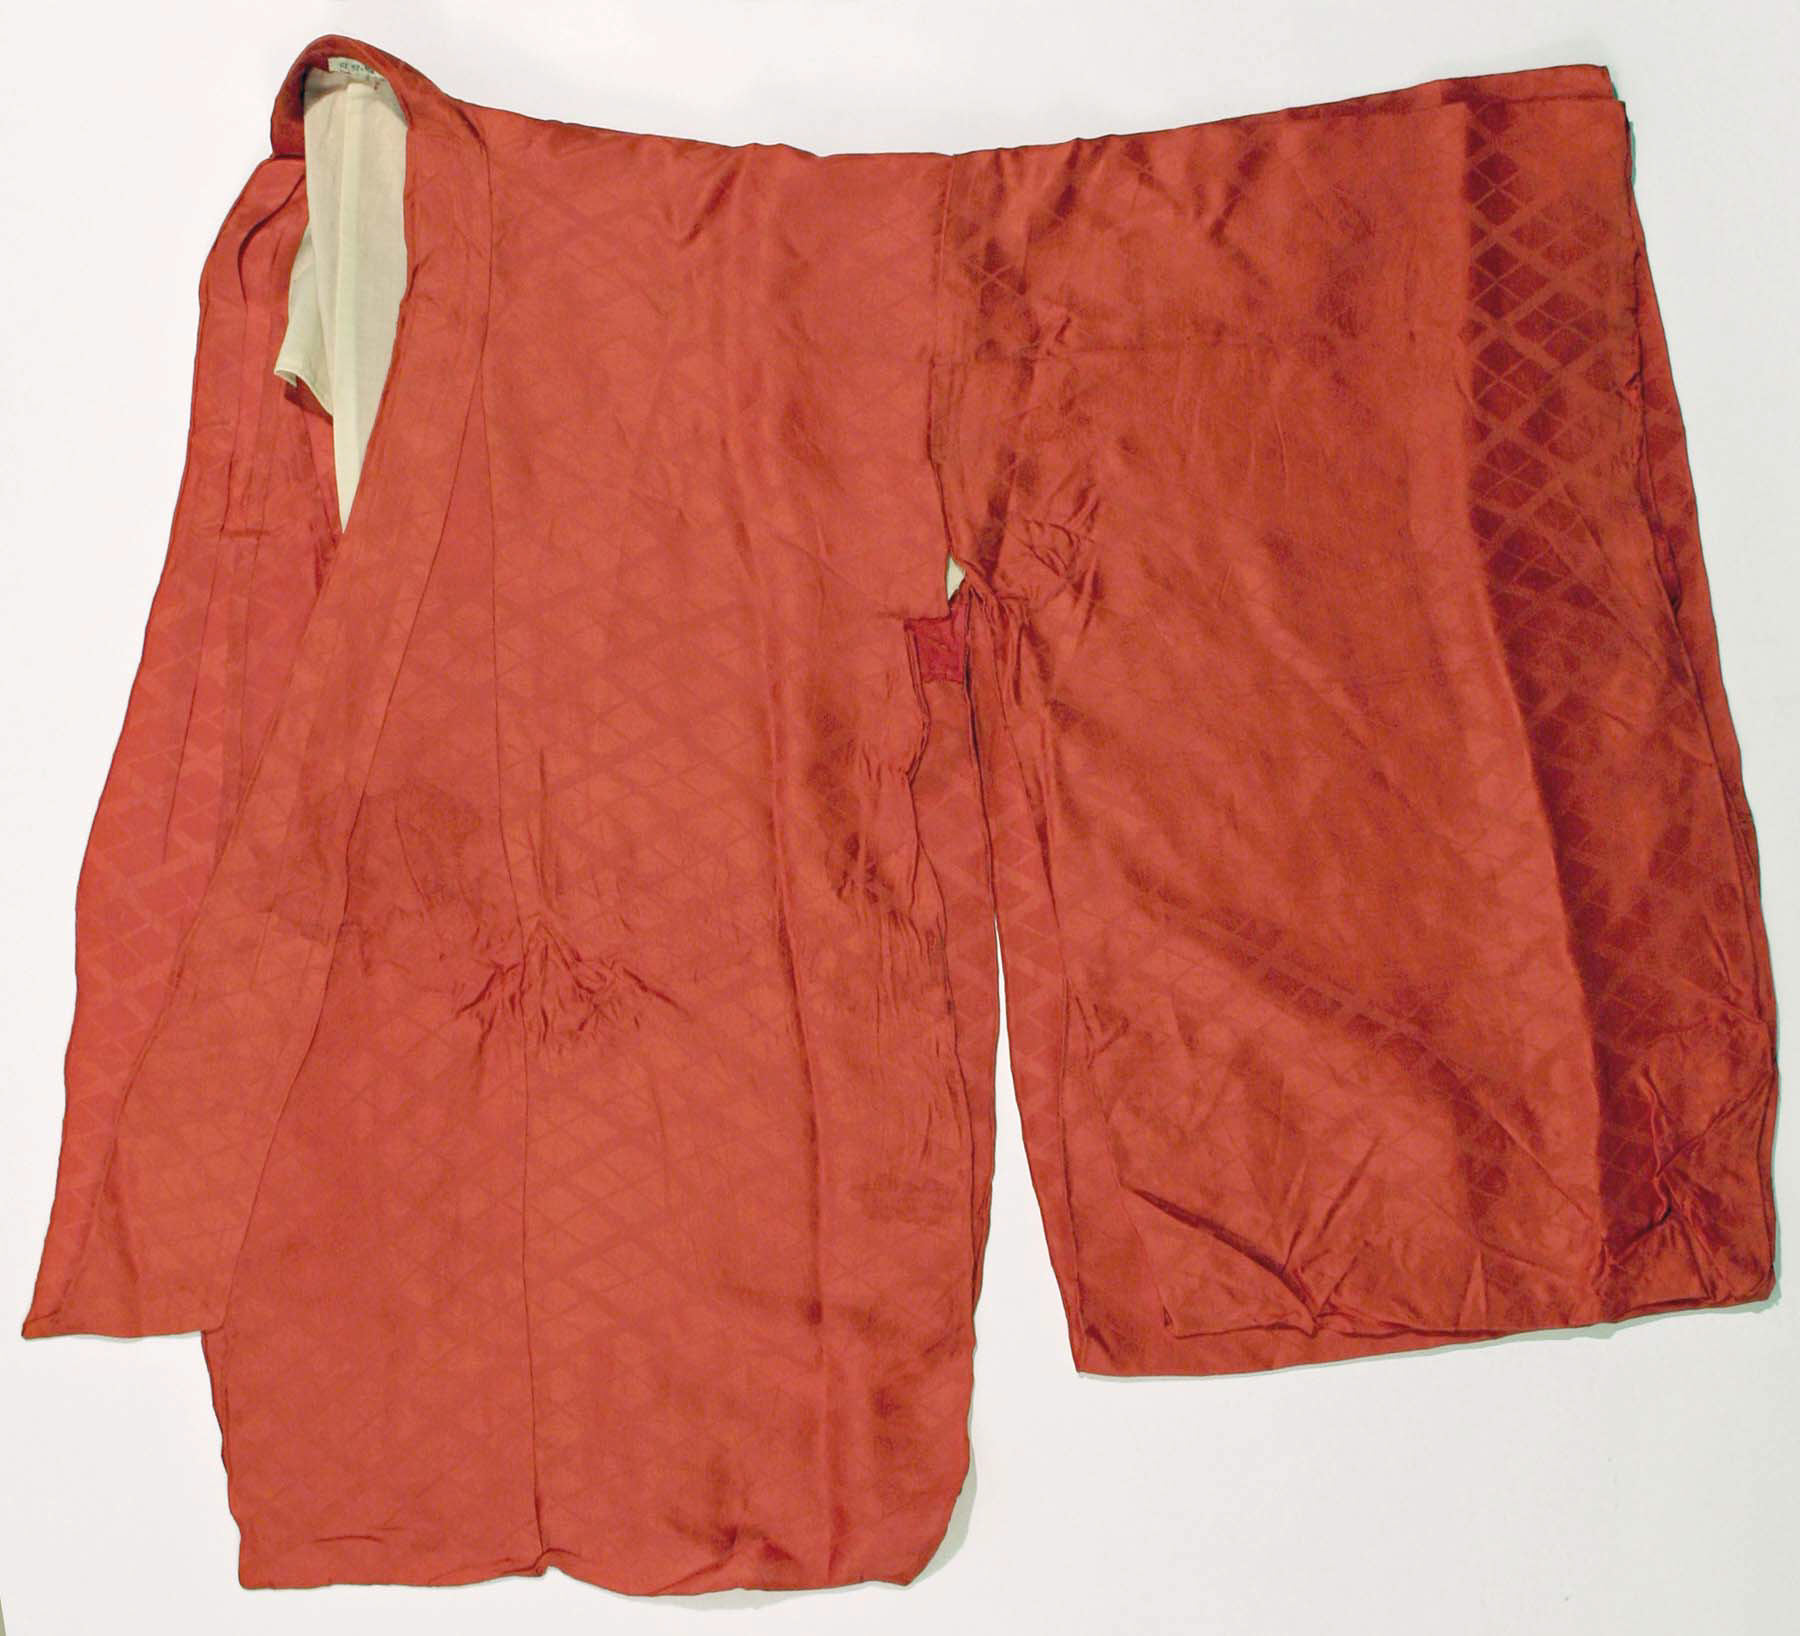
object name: ensemble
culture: japanese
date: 1800-1957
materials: silk